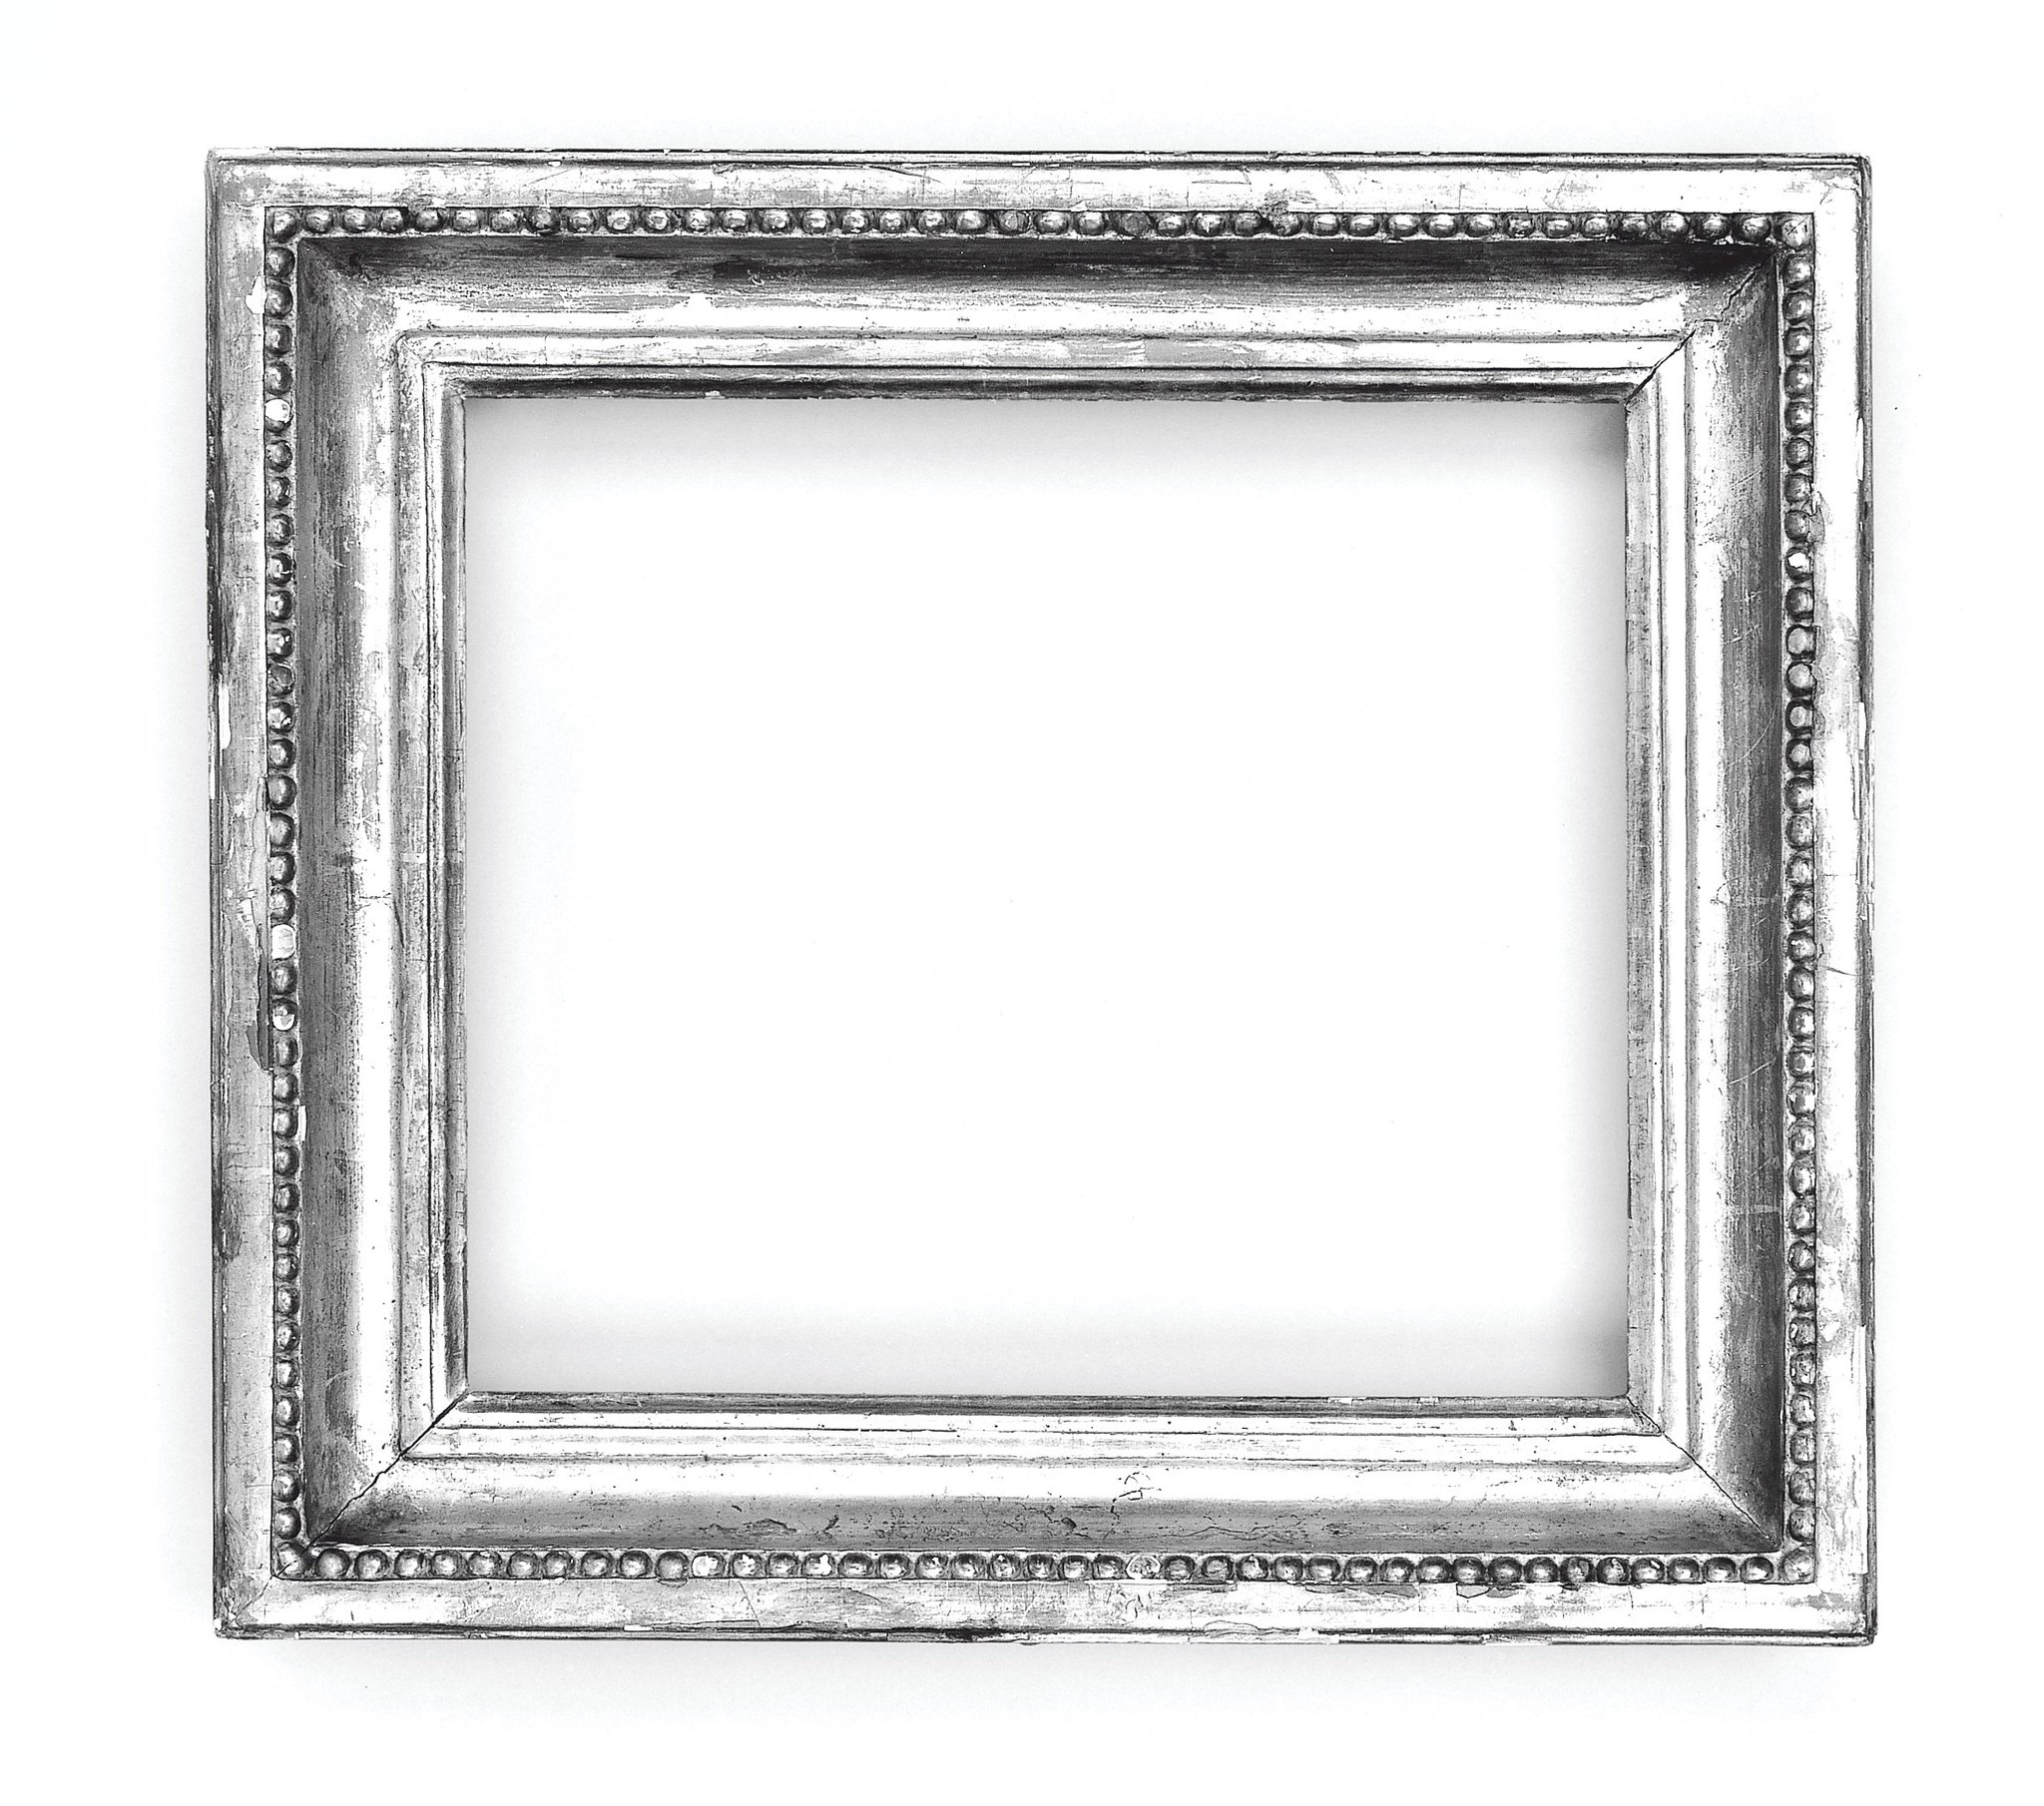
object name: frame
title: Hollow molding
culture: american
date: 1801-1833